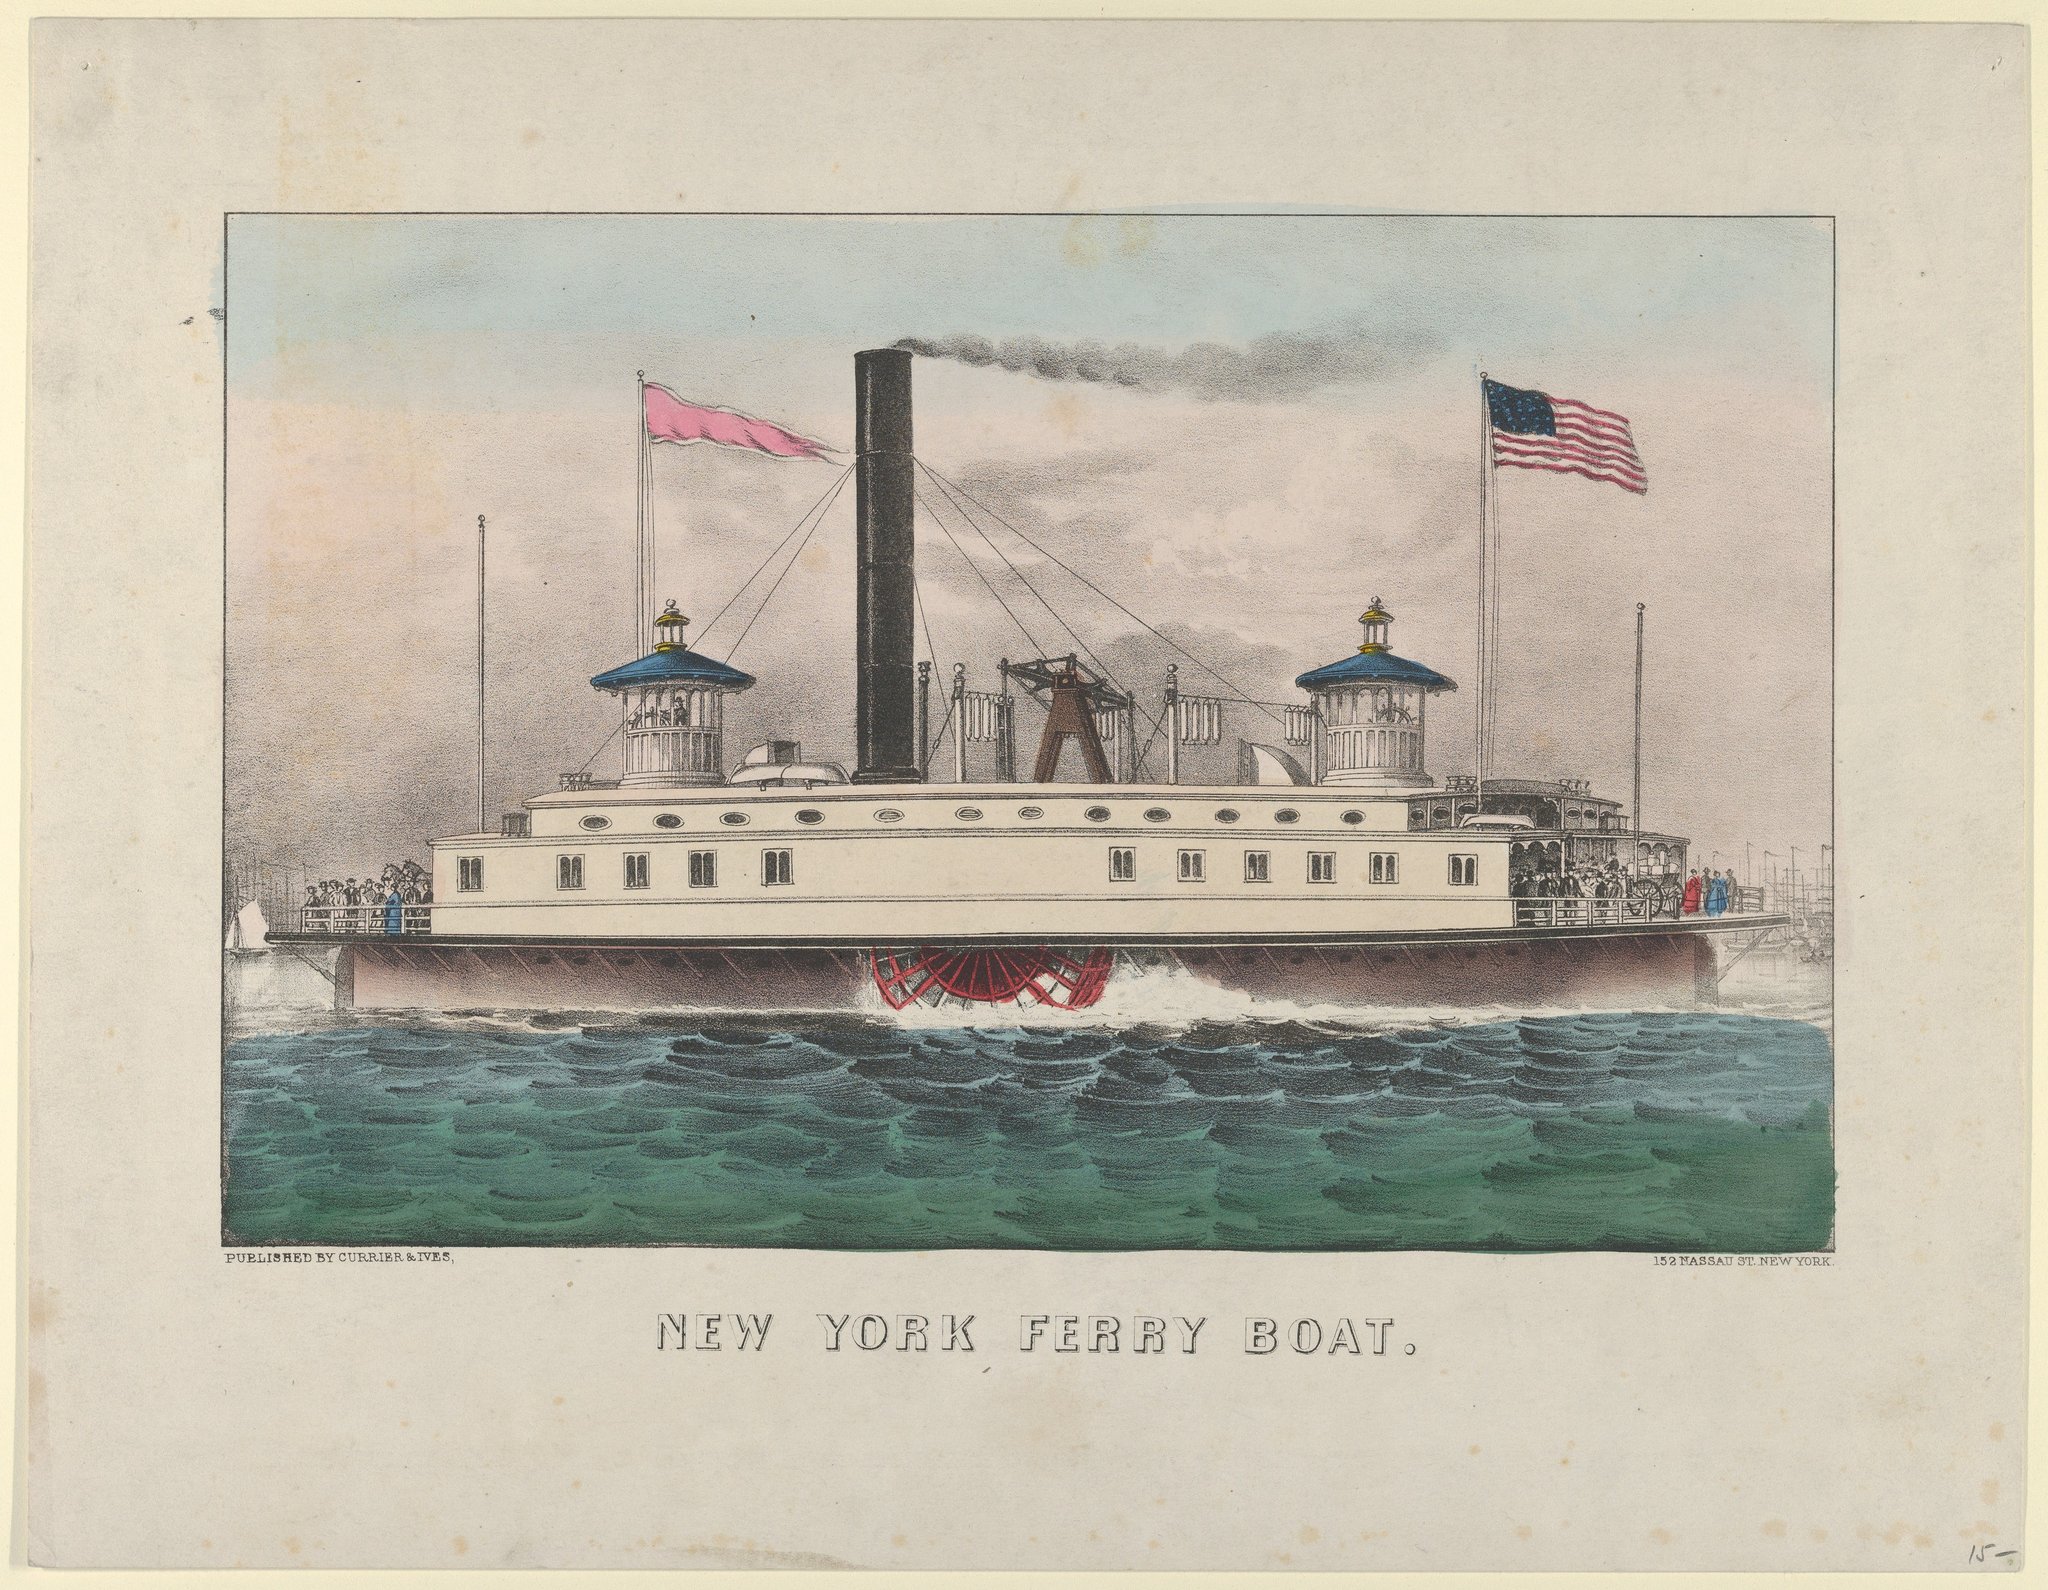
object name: print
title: New York Ferry Boat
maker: currier & ives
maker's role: lithographer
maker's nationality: american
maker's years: 1857-1907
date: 1860-1865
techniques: hand coloring, lithograph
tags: boats